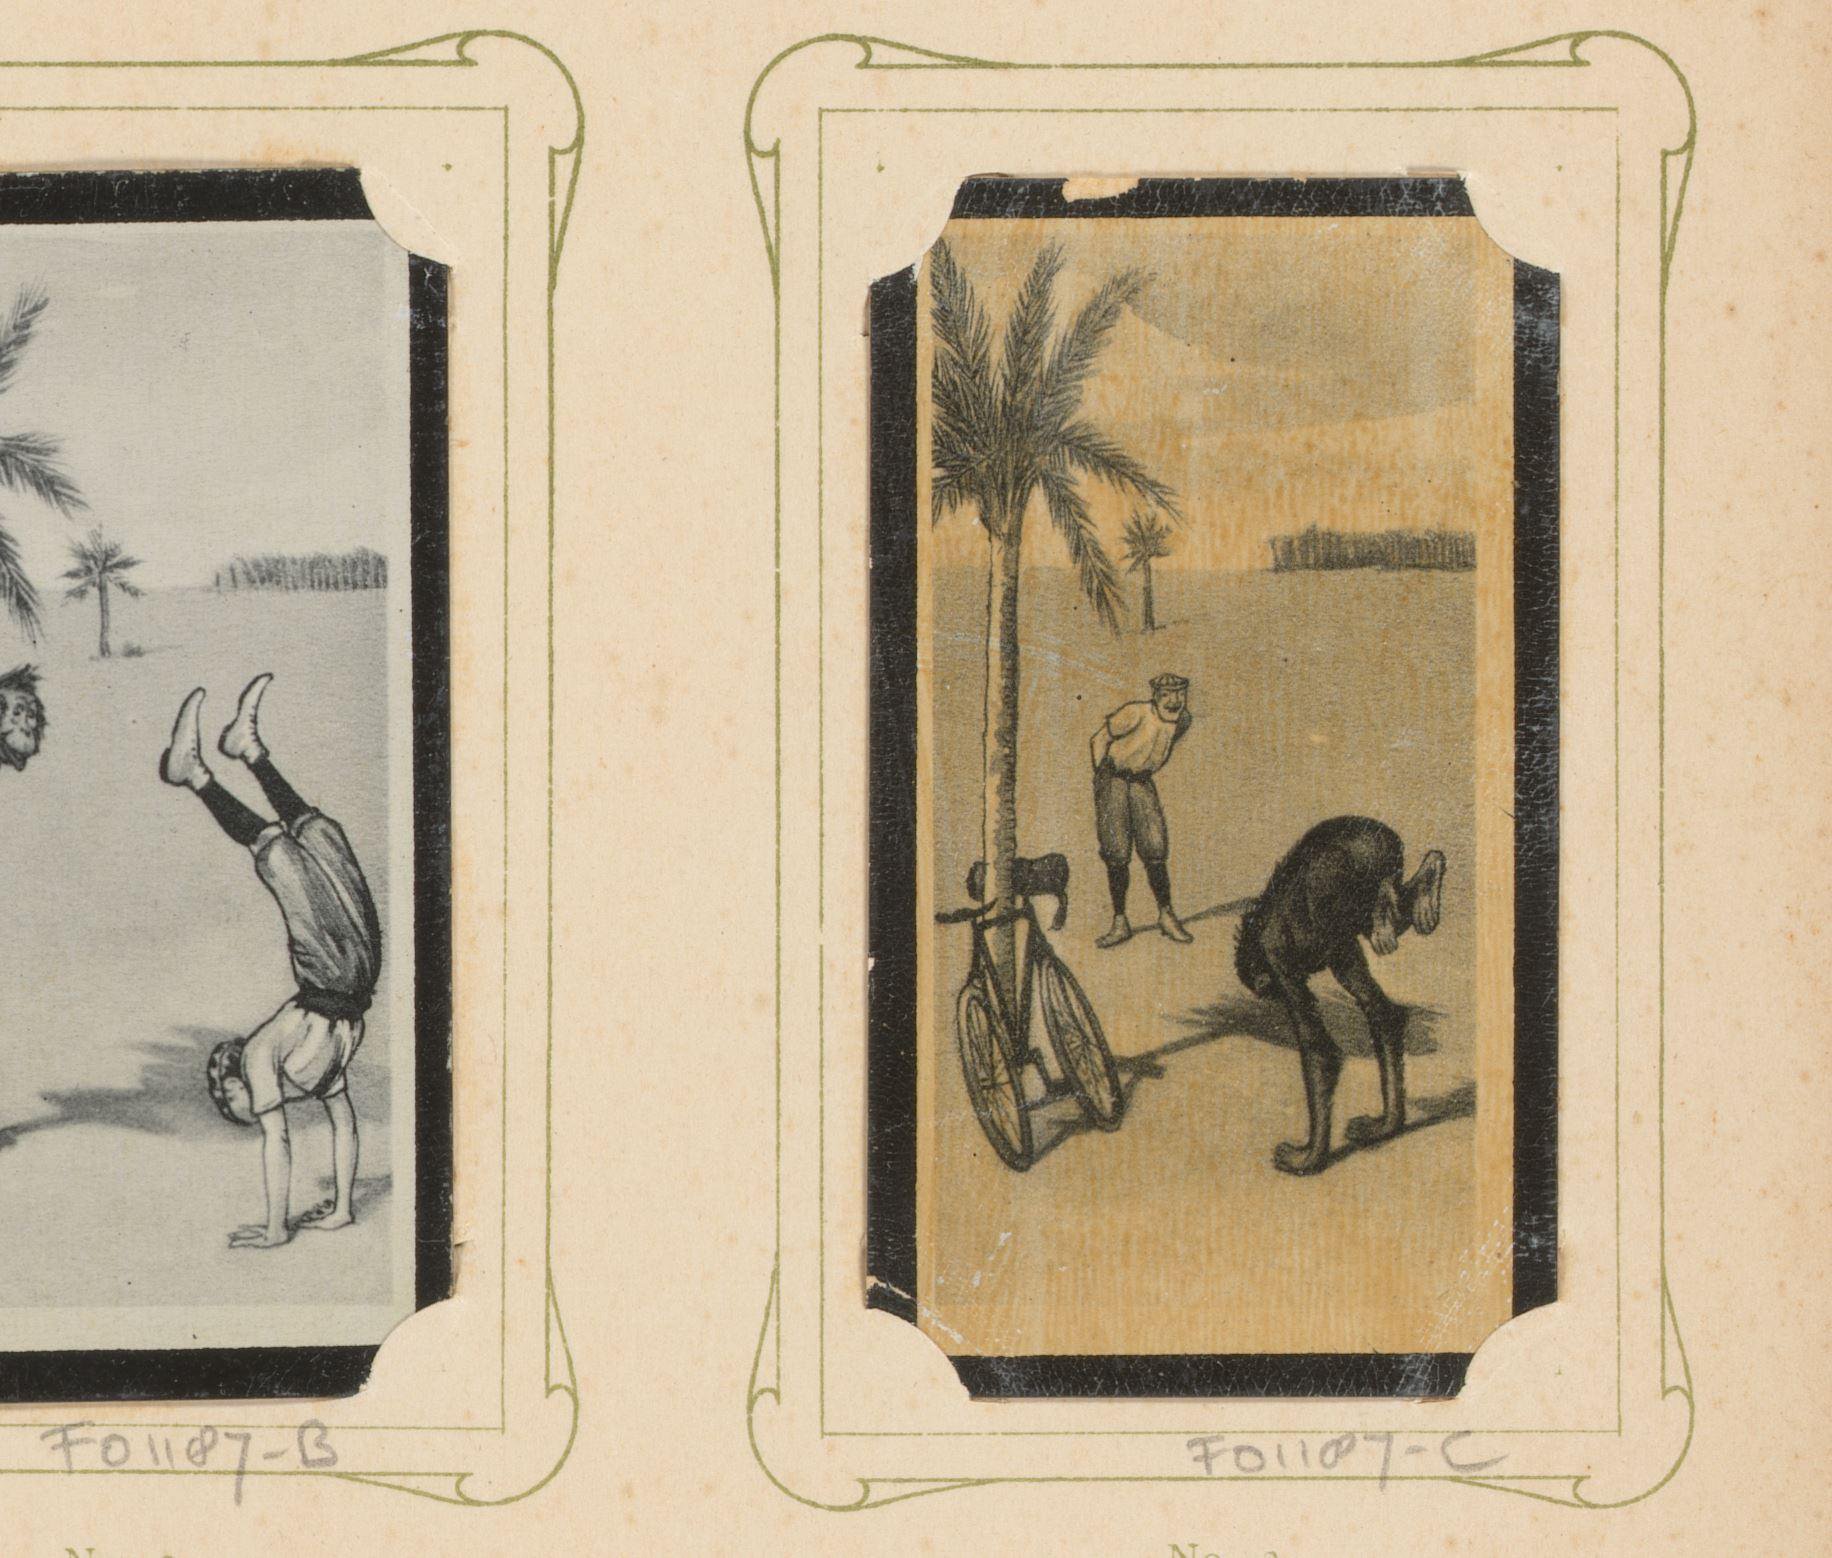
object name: reproduction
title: Reproductie van een tekening van een aap die een handstand doet voor een jongen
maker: Anonymous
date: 1905-1906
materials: paper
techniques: photograph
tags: trees, monkeys, apes, youth, adolescent, standing on the head or on the hands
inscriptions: inscription: ‘No. 3./ Dat gaat best.’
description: Deze prent maakt deel uit van een album.